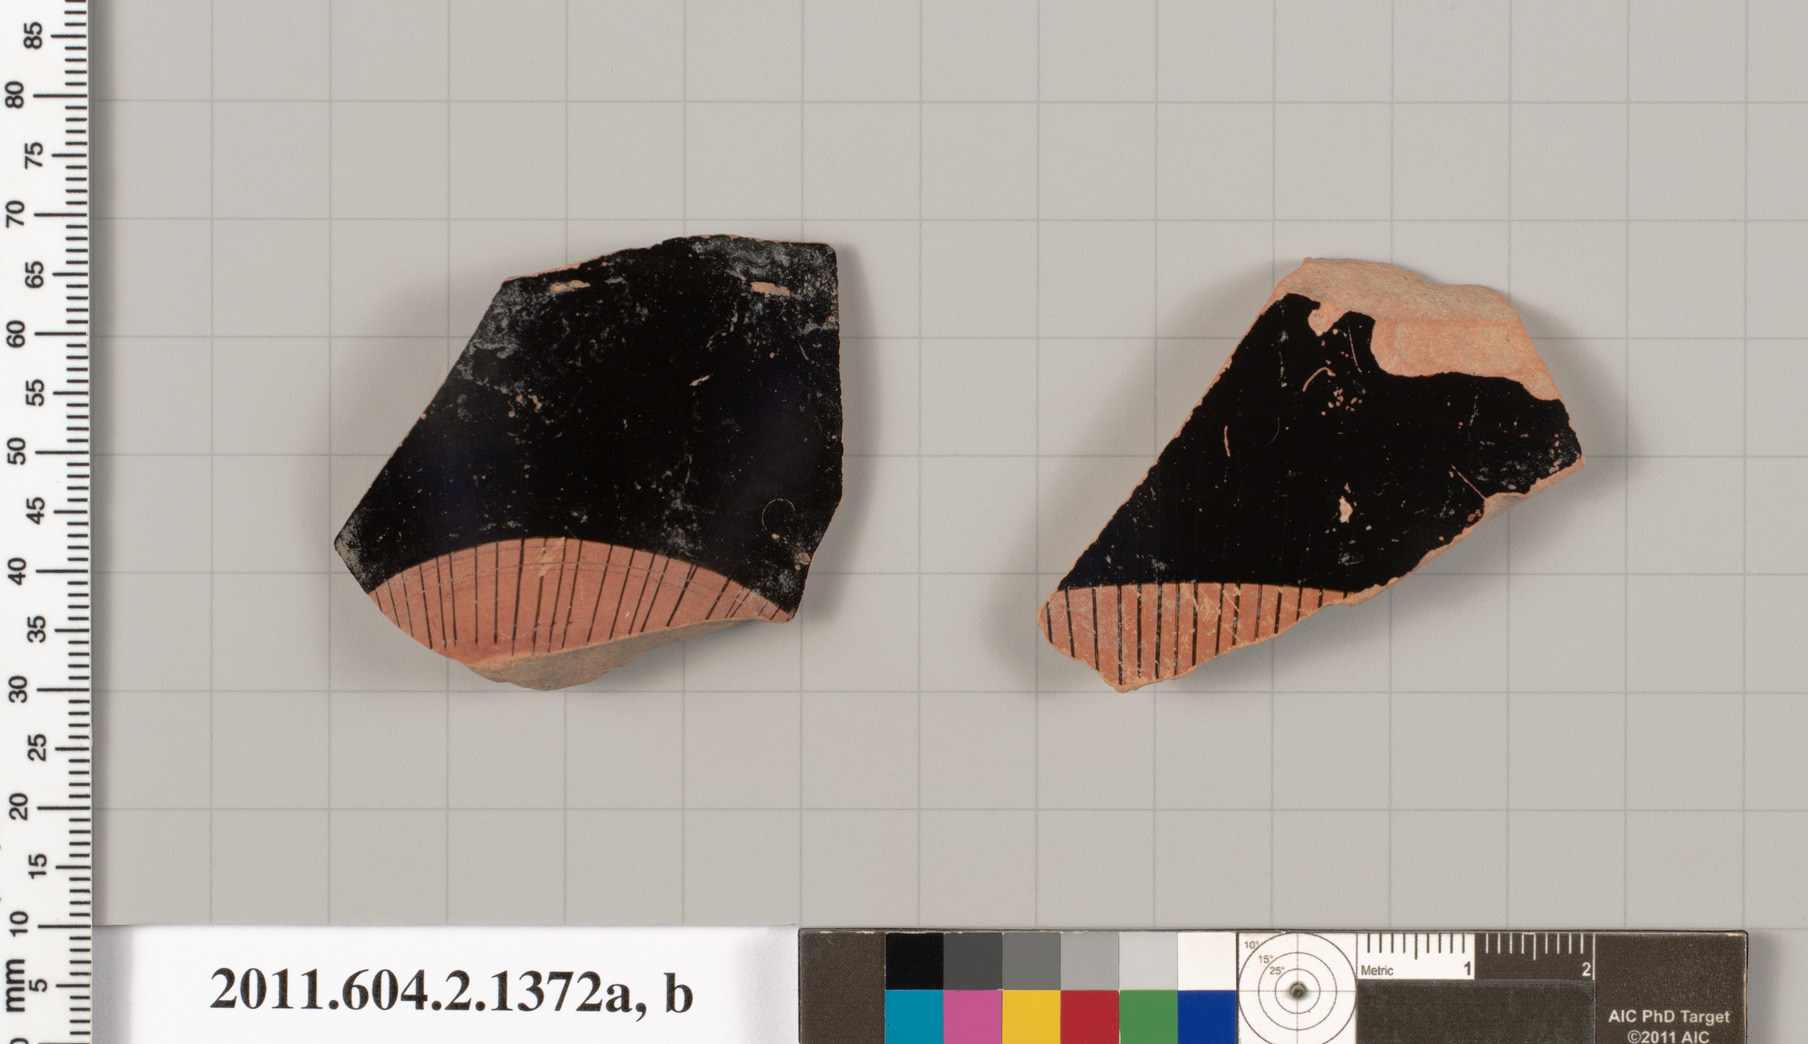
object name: skyphos fragment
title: Terracotta fragments of skyphoi (deep drinking cups)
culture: greek, attic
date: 475-451 BCE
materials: terracotta